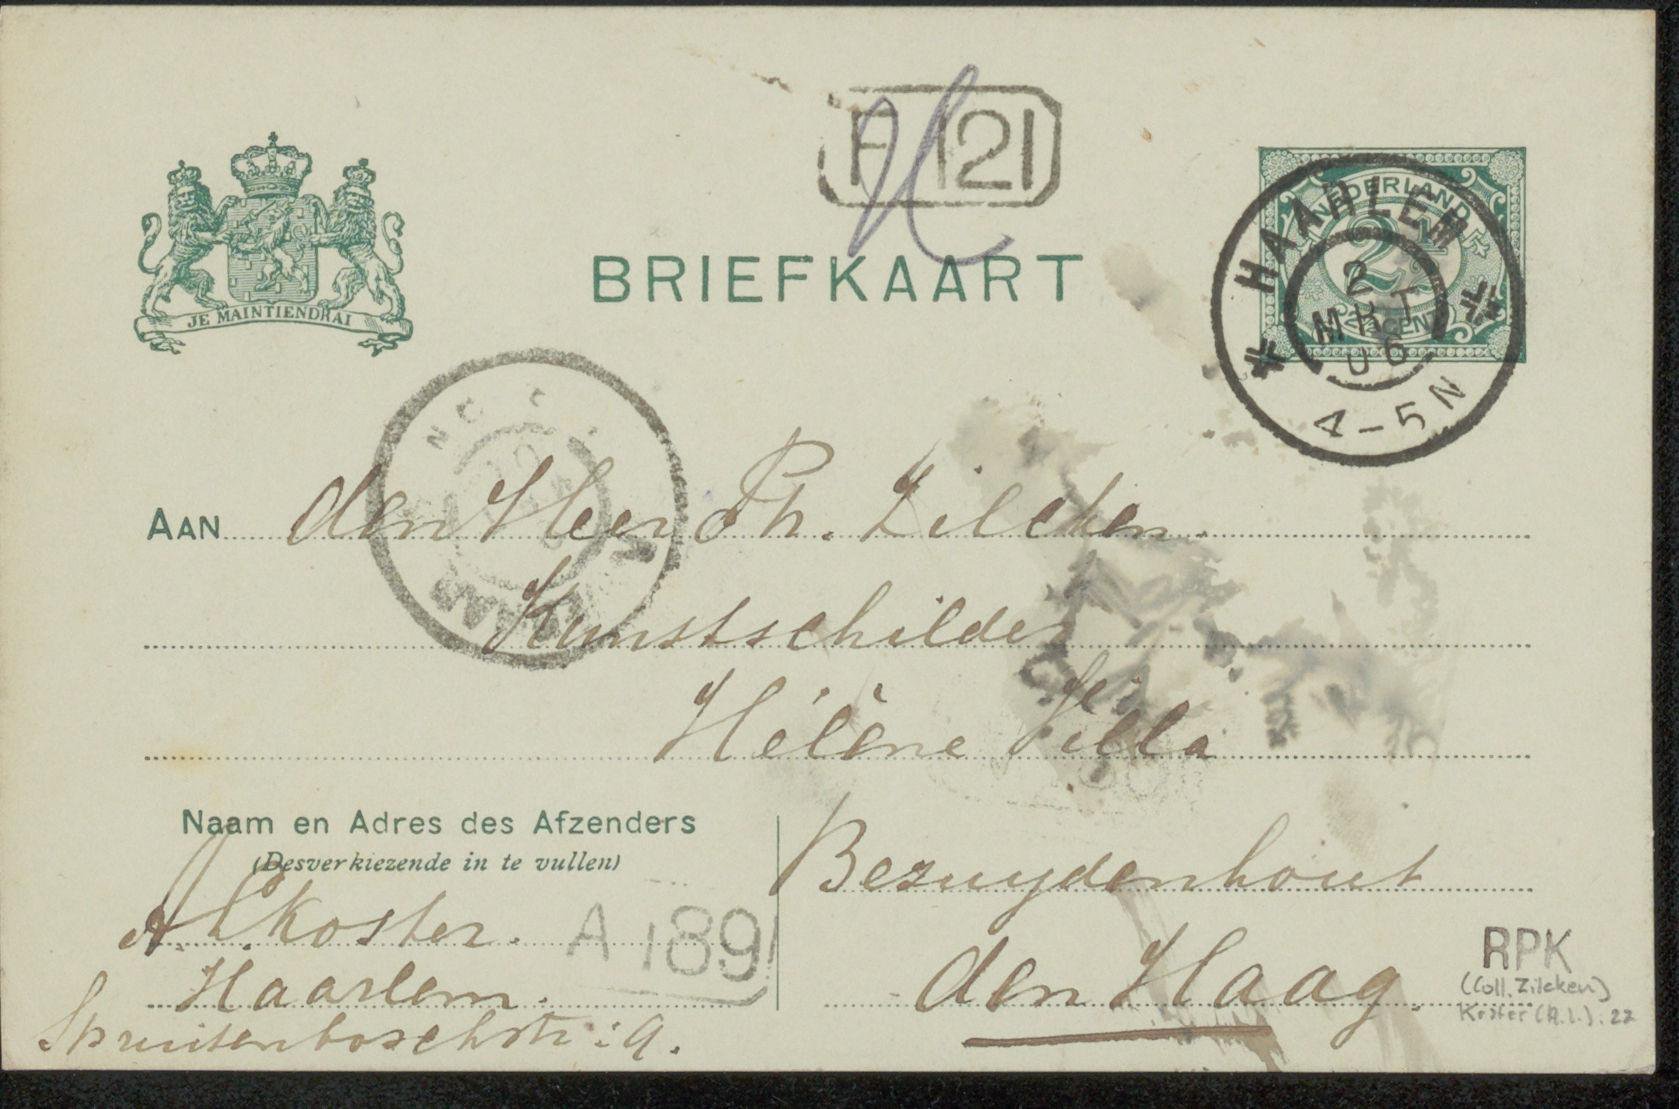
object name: postcard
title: Briefkaart aan Philip Zilcken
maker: anton l. koster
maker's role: draughtsman, painter, print maker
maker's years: 1859-1937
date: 1906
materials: cardboard, ink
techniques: pen, writing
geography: haarlem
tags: the hague, painter, draughtsman, philip zilcken, the graphic arts, printed matter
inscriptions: collector's mark: ‘RPK’